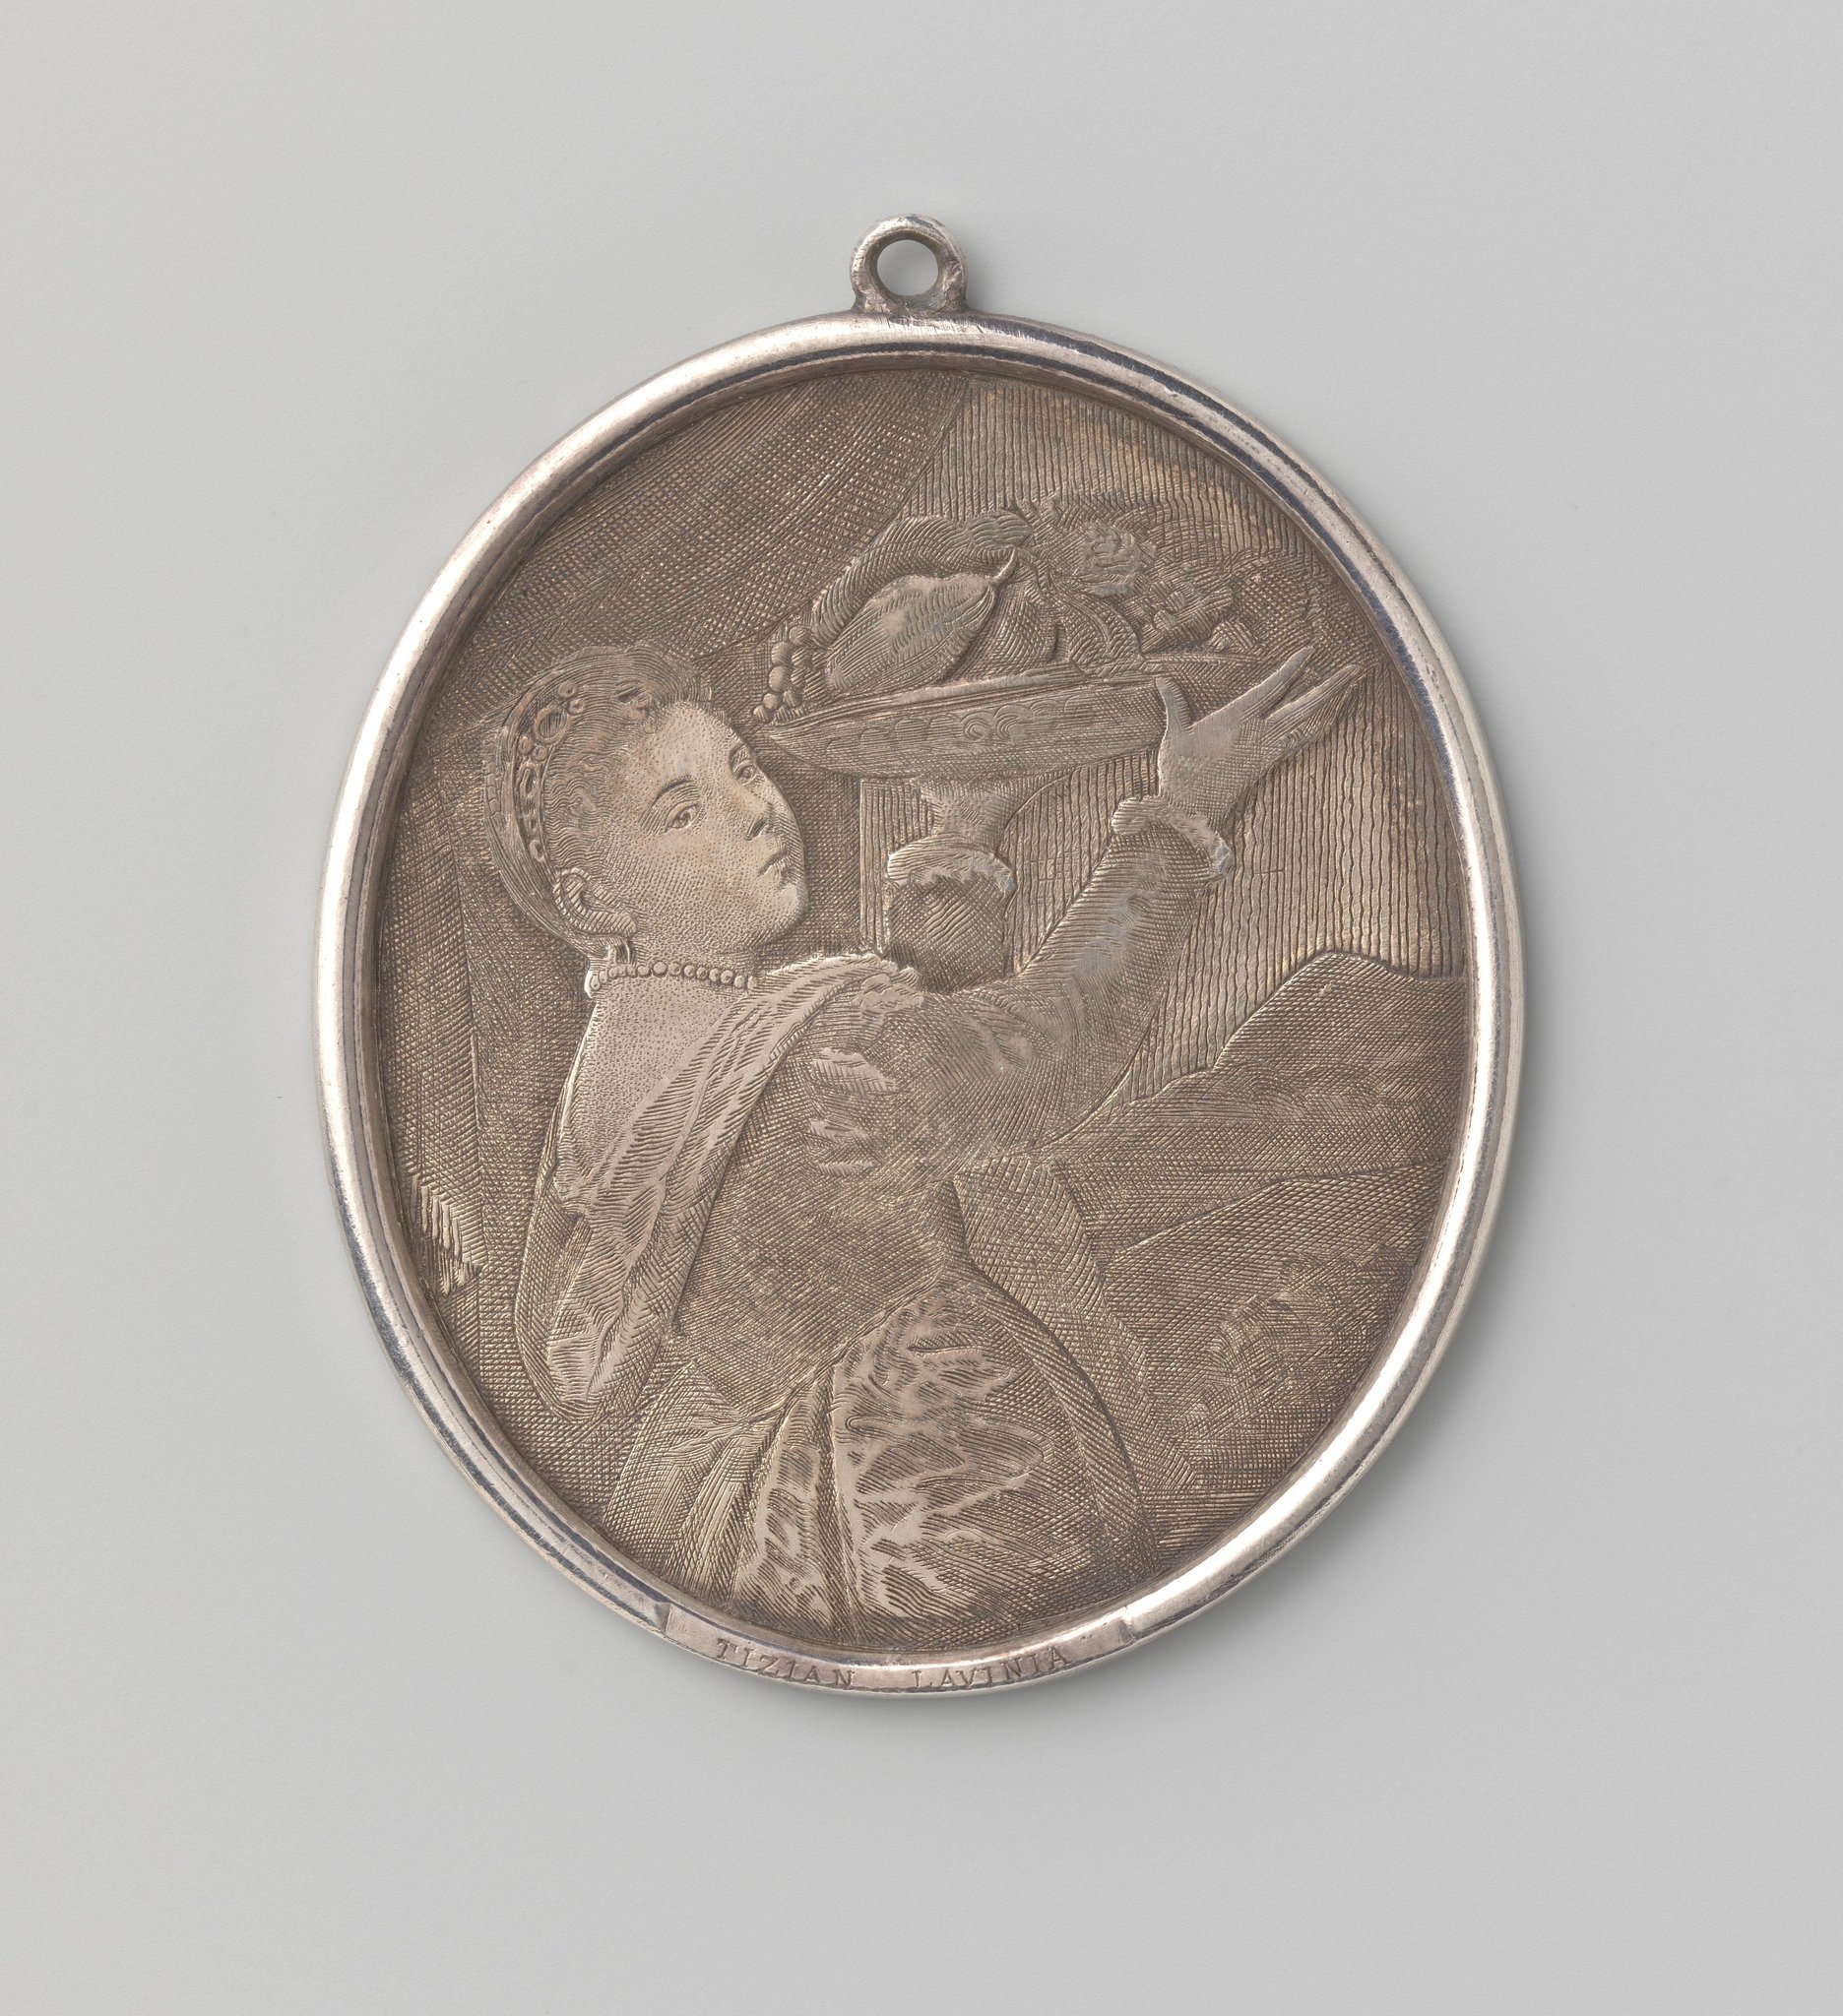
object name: draagpenning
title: Gegraveerde draagpenning gebaseerd op 'Meisje met de fruitschaal' door Titiaan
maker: Anonymous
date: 1750-1800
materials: silver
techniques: engraving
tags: venice, painter, draughtsman, titiaan, adolescent, young woman, maiden, fruit, bowl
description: Voorzijde: meisje met opgeheven fruitschaal in haar handen, keerzijde blanco.